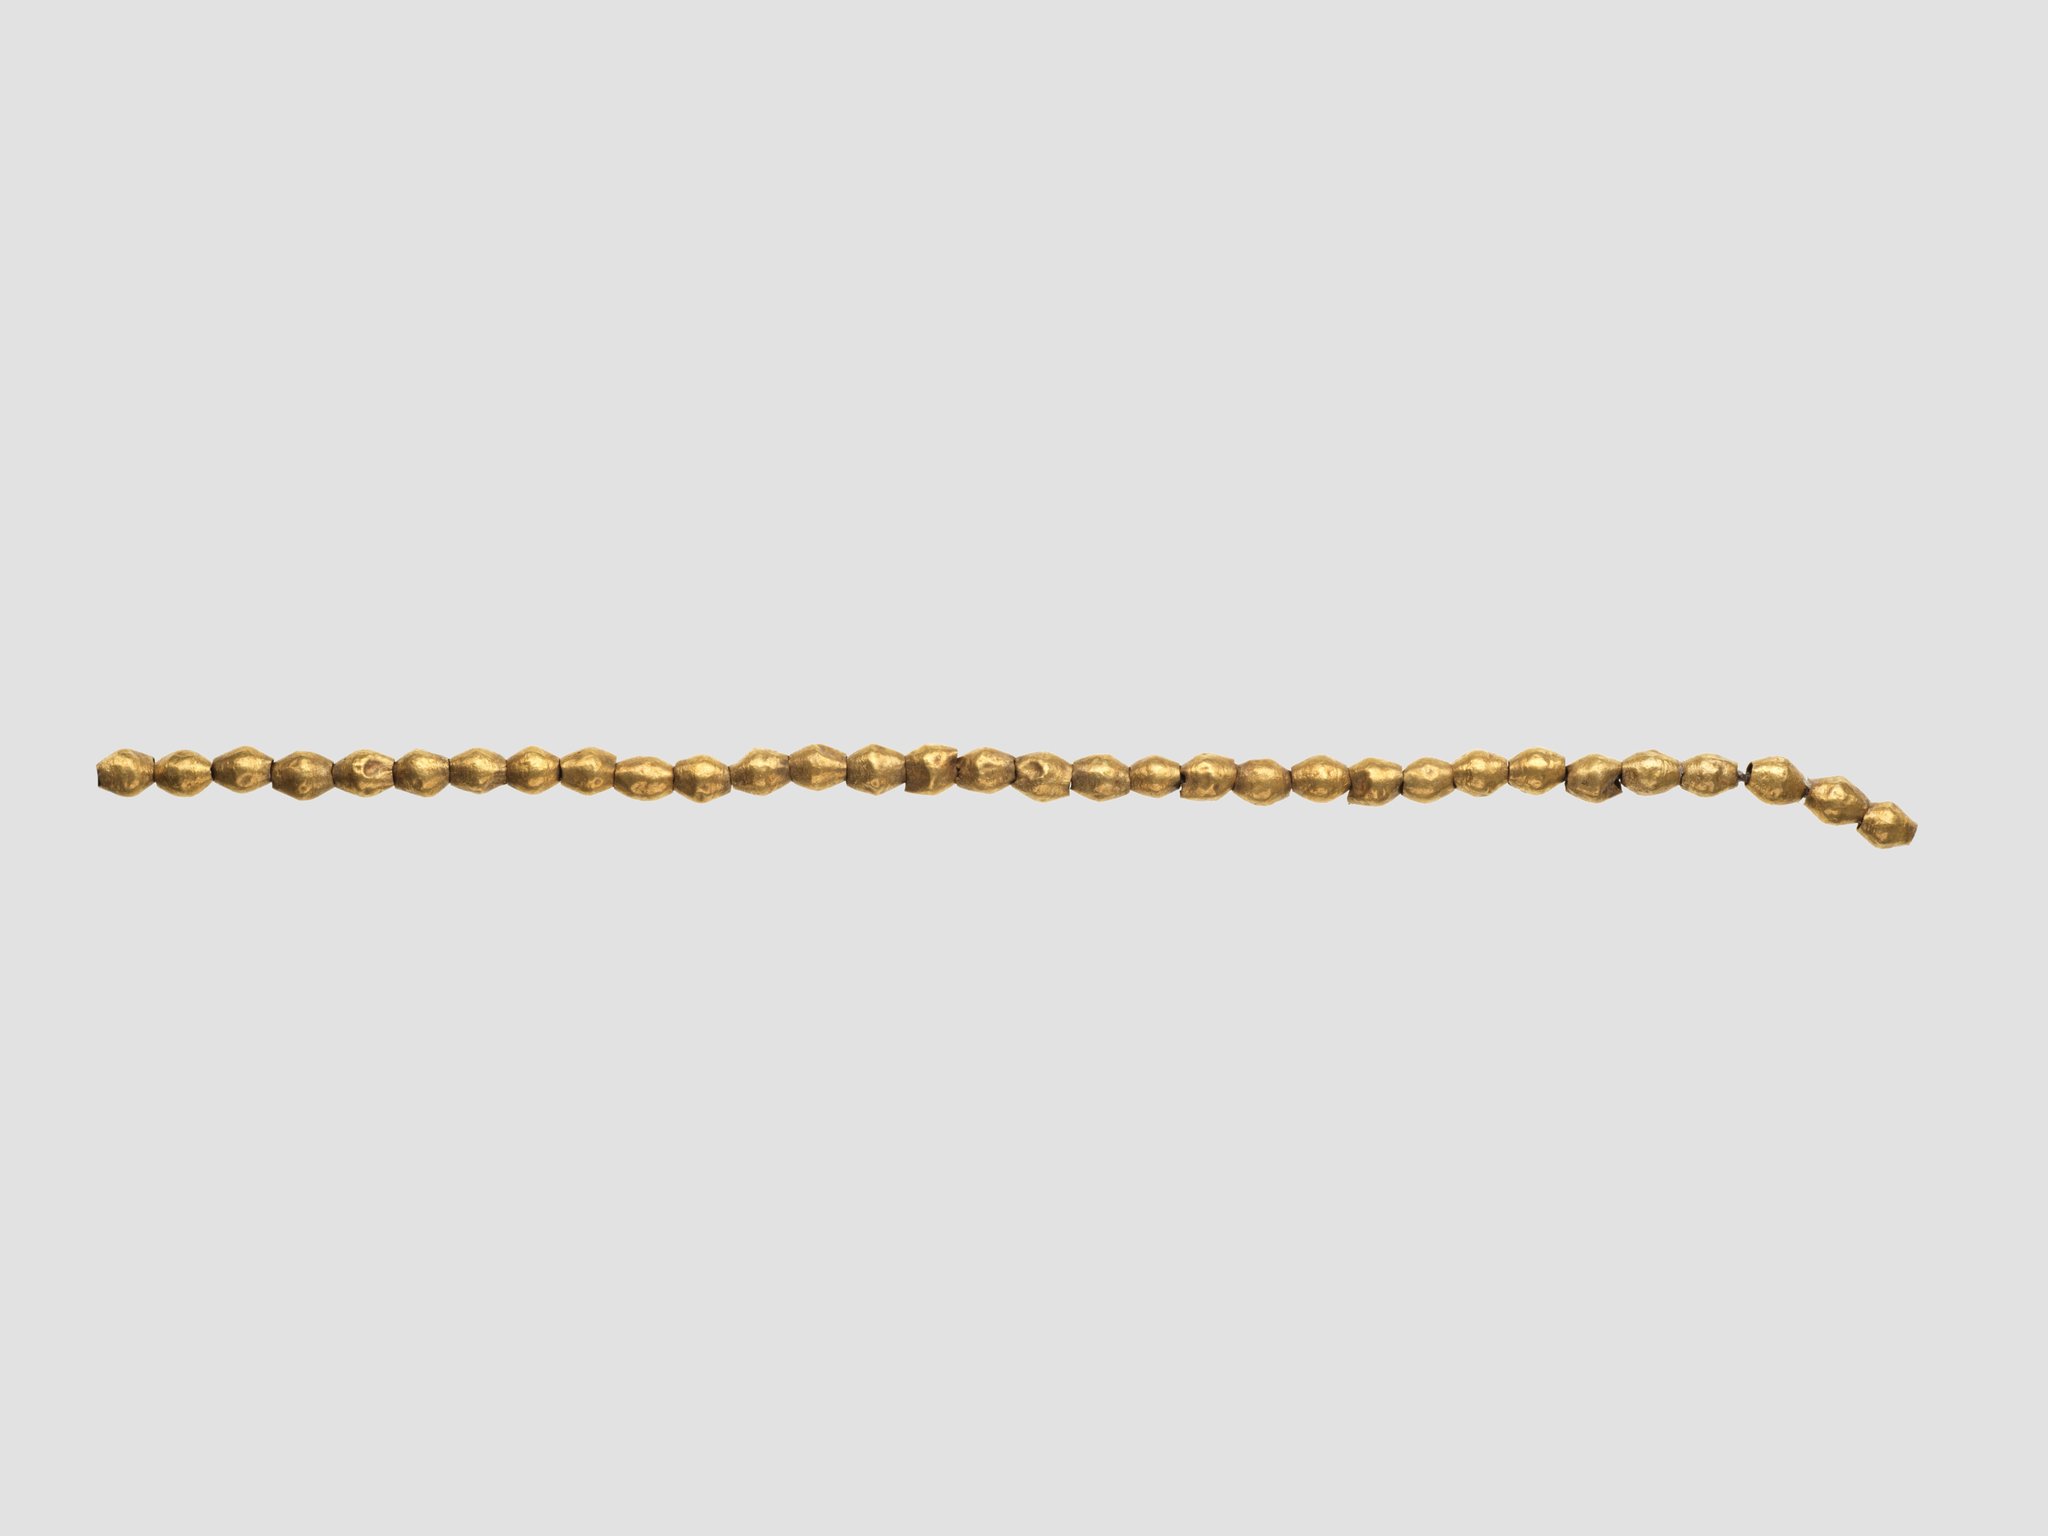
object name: bead and pendant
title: Necklace pendants and beads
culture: babylonian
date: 1700-1501 BCE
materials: gold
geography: mesopotamia